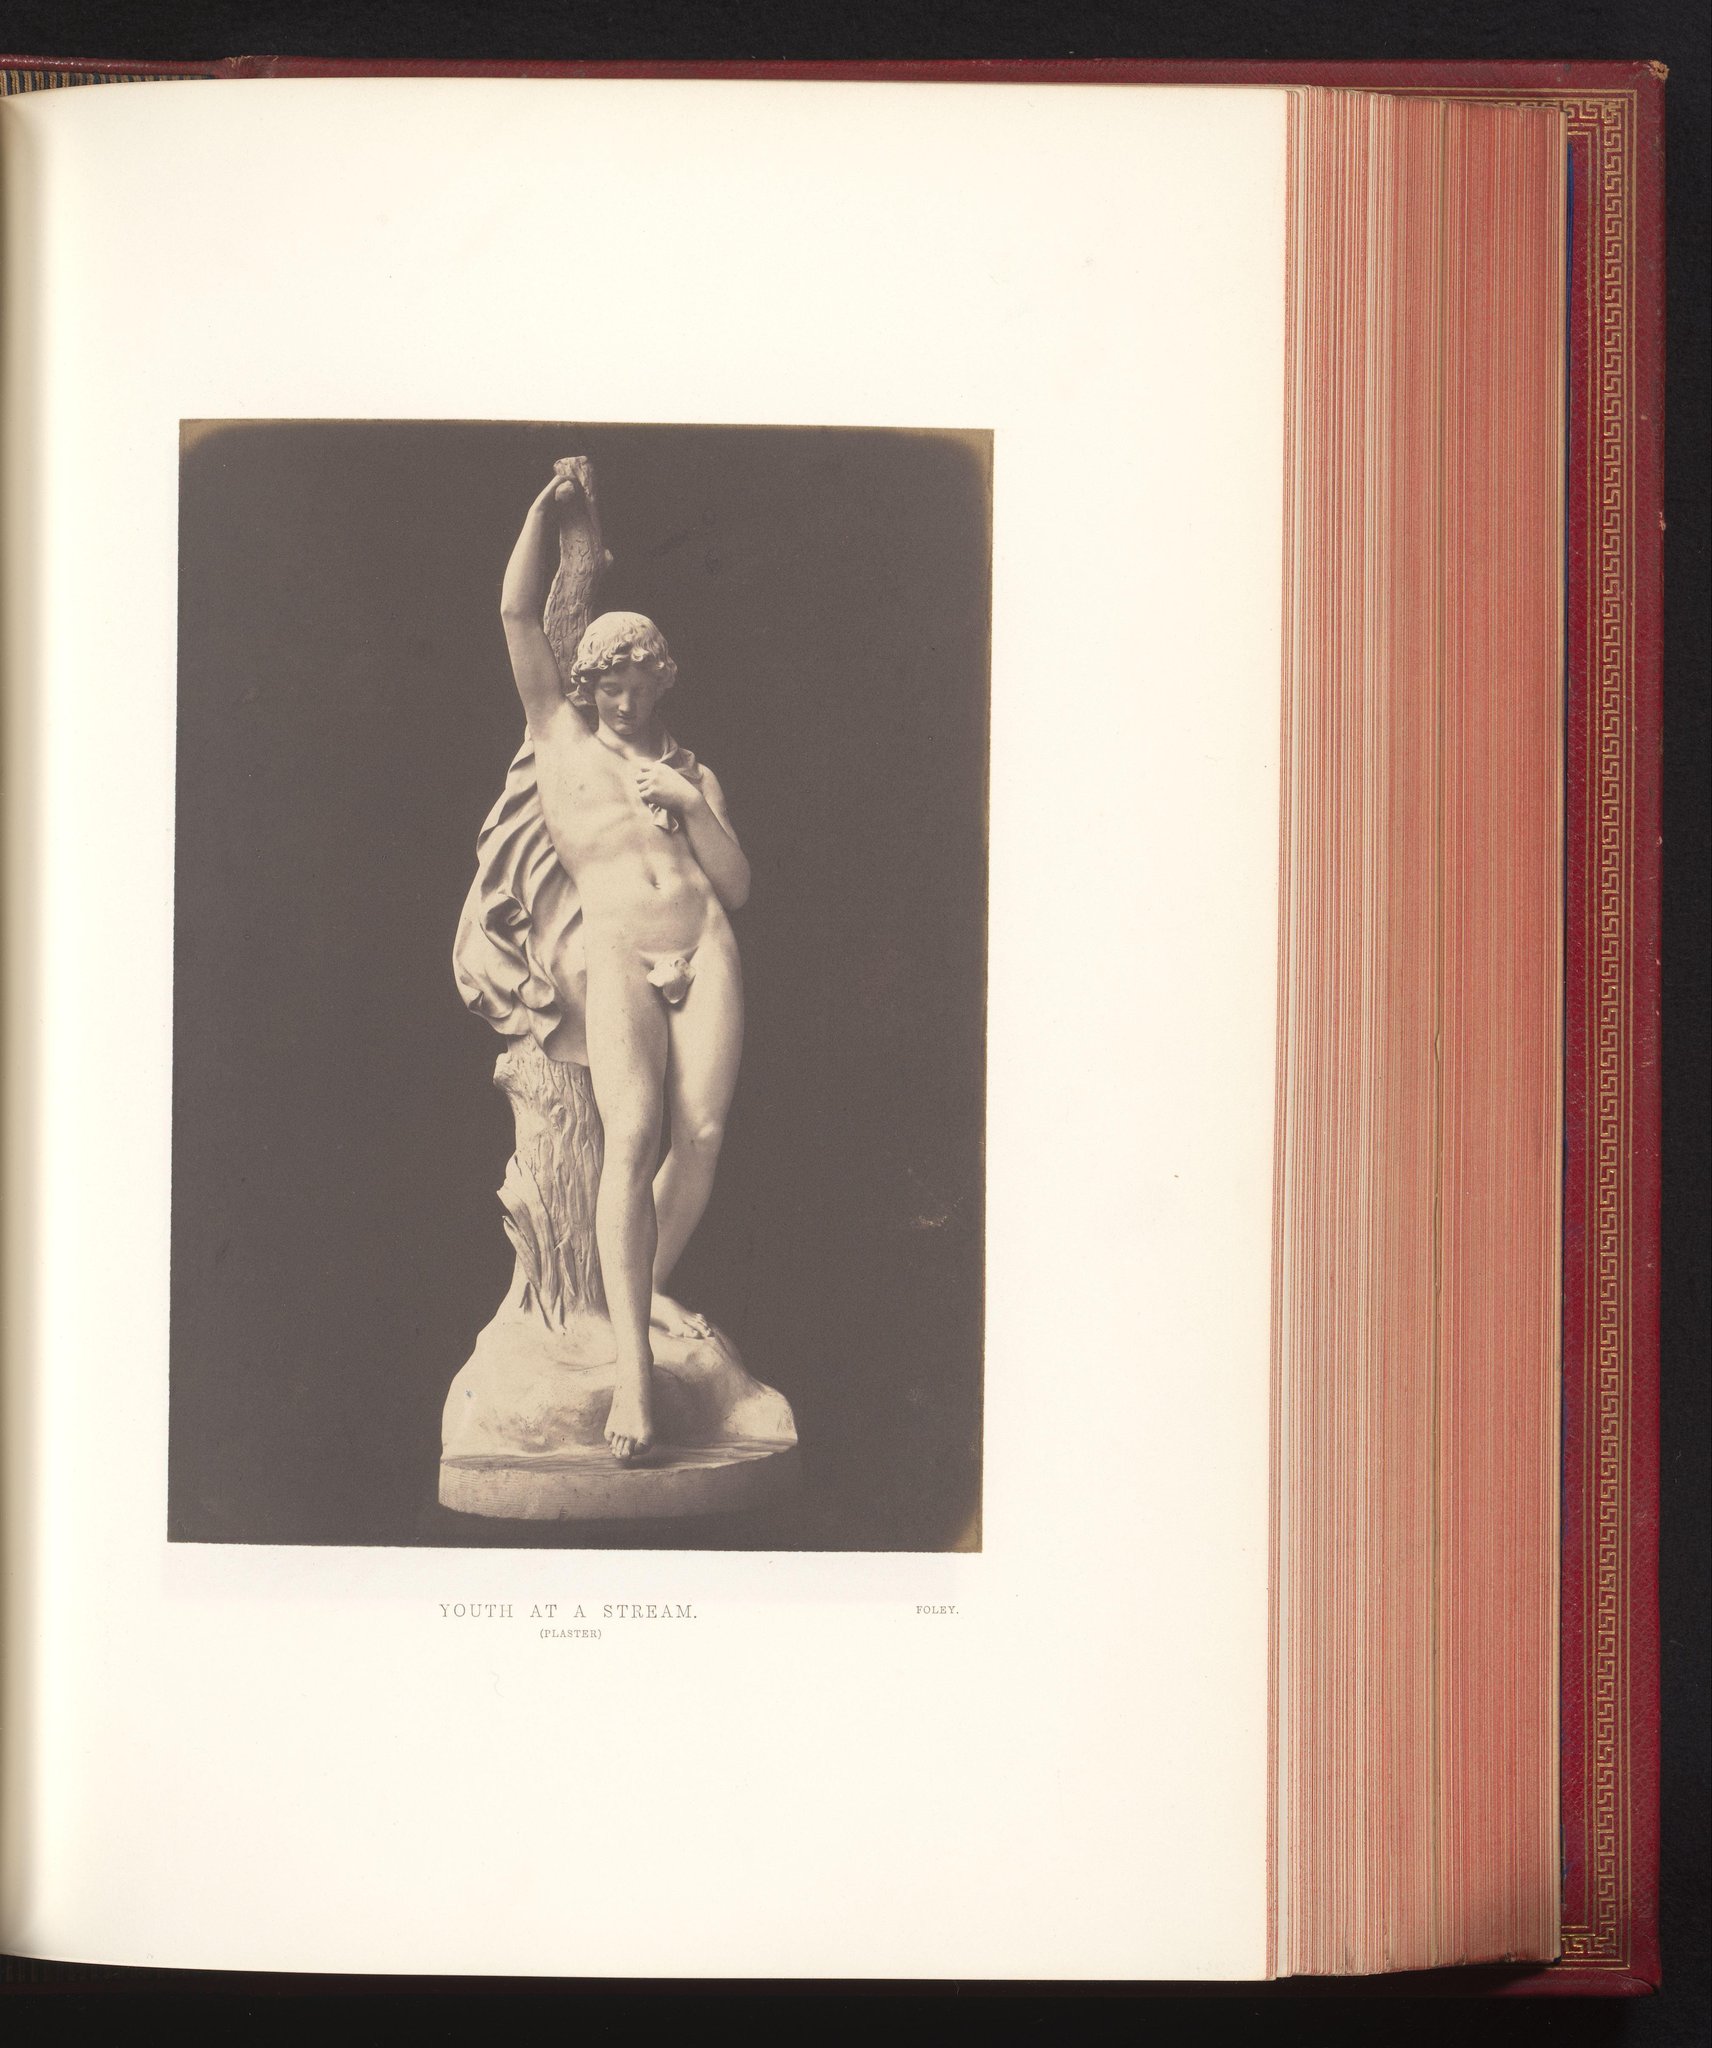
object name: photograph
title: Sculptuur door John Henry Foley, voorstellend een jonge man bij een rivier, tentoongesteld op de Great Exhibition of the Works of Industry of All Nations van 1851 in Londen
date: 1851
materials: photographic support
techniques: salted paper print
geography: london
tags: piece of sculpture, reproduction of a piece of sculpture, london